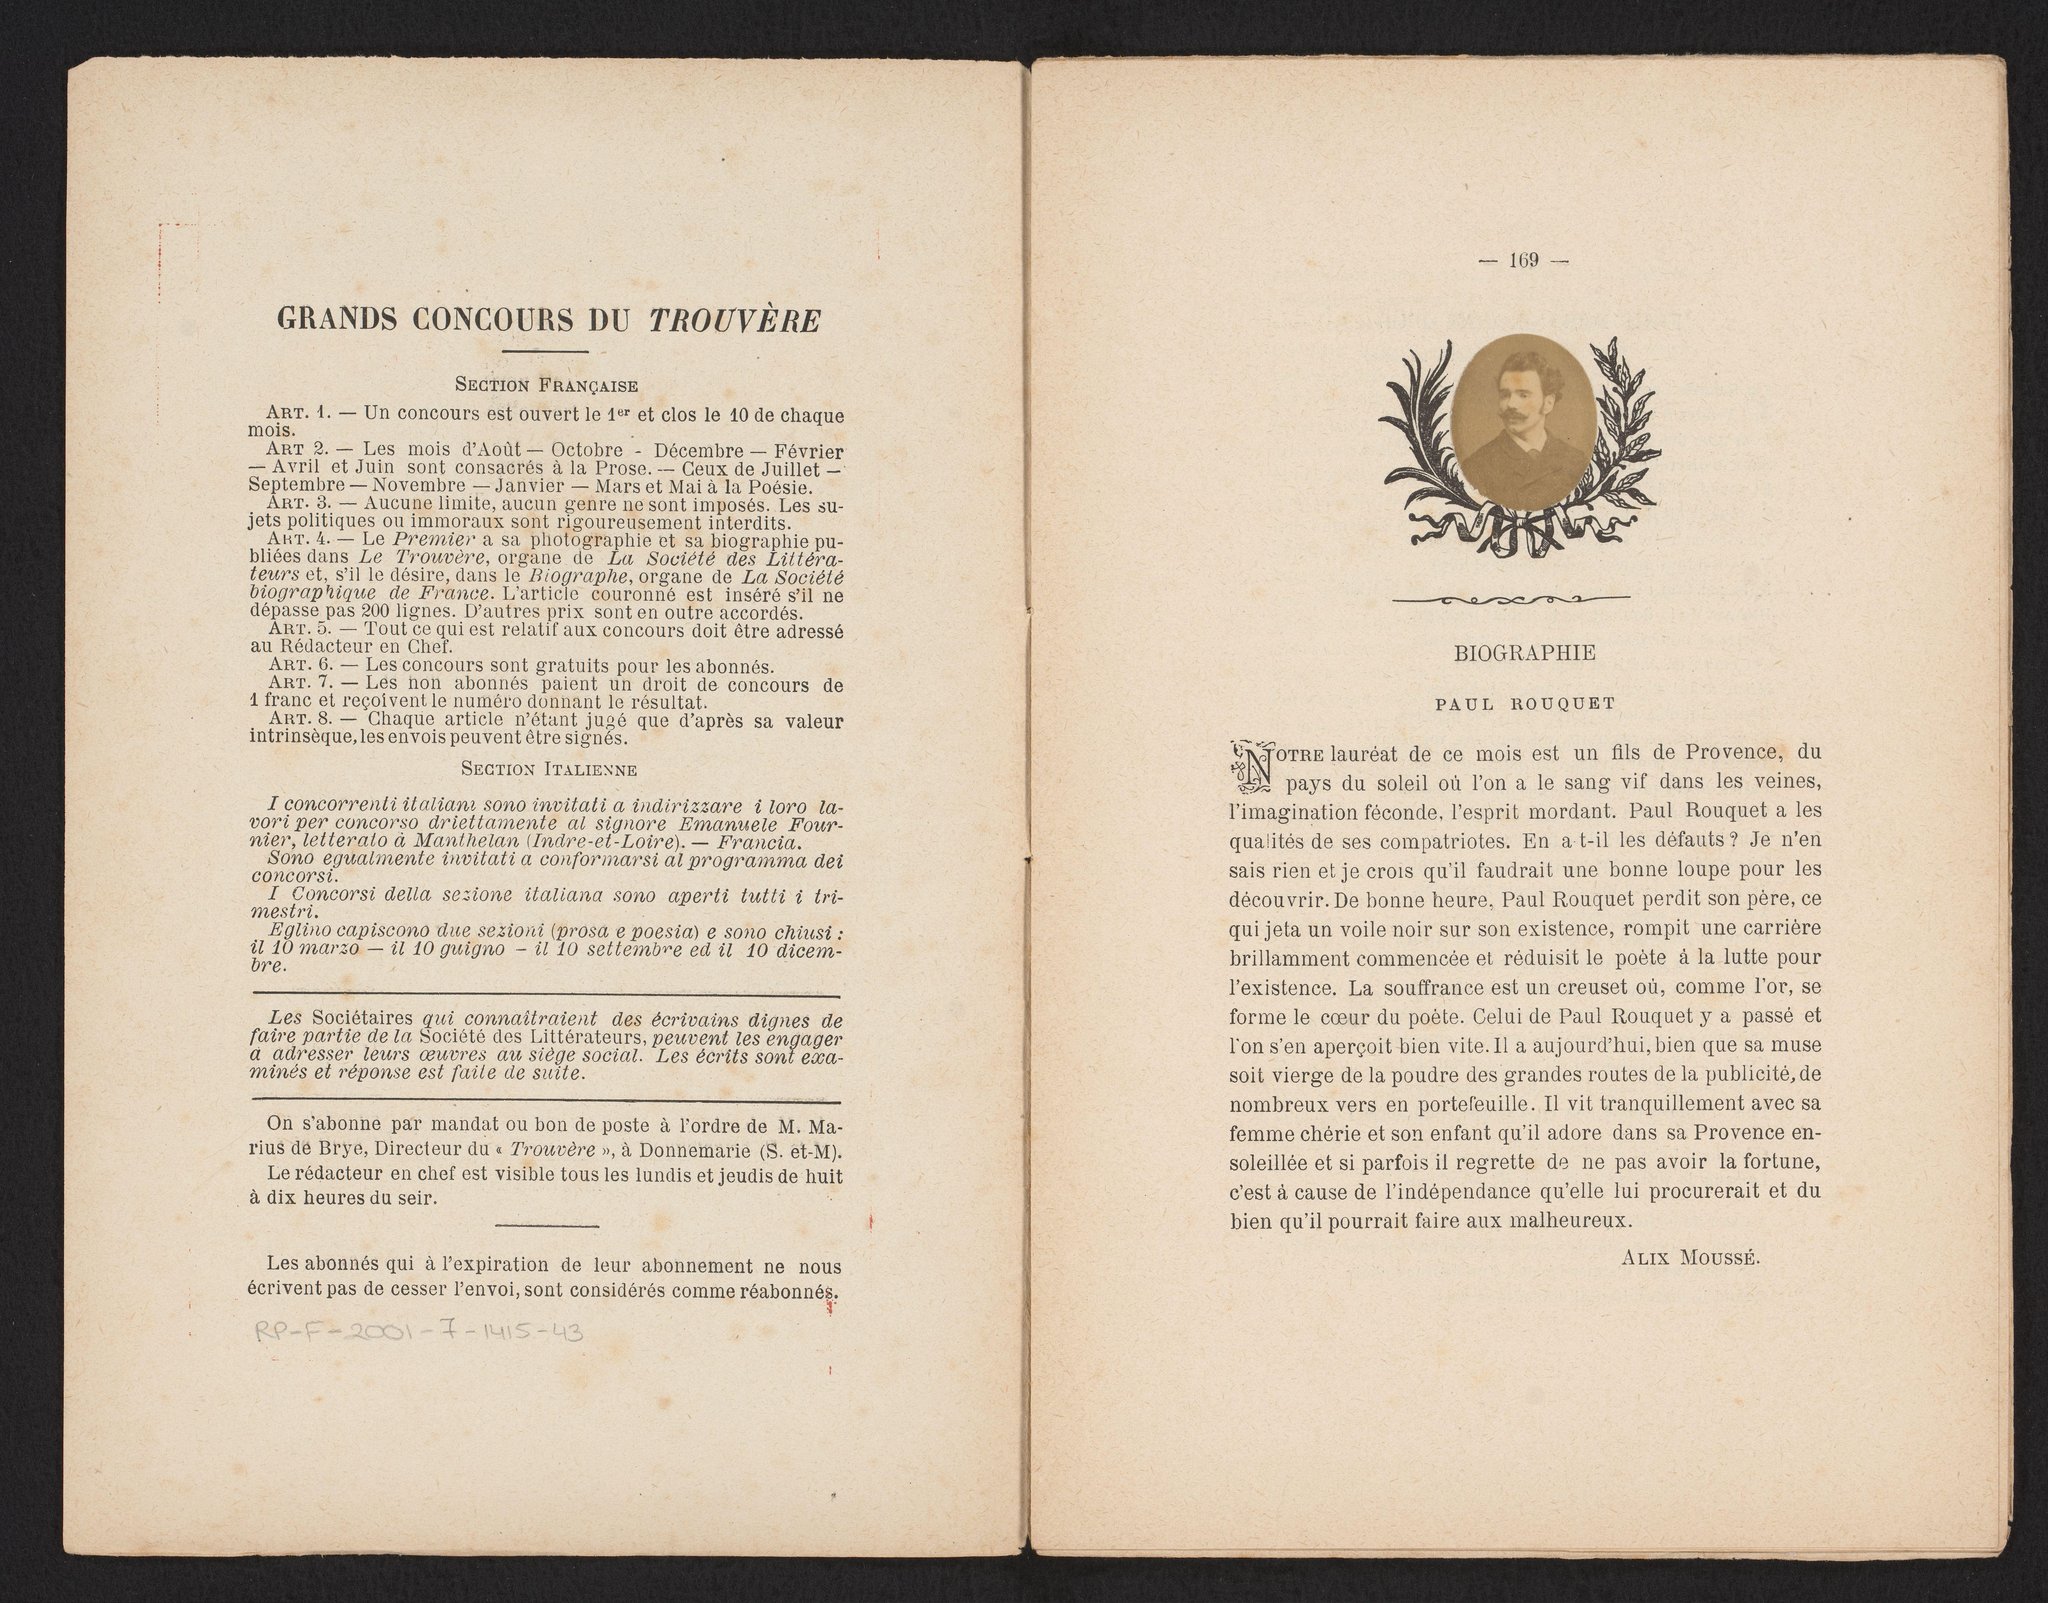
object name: page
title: Portret van Paul Rouquet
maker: Anonymous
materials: photographic support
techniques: albumen print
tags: historical persons